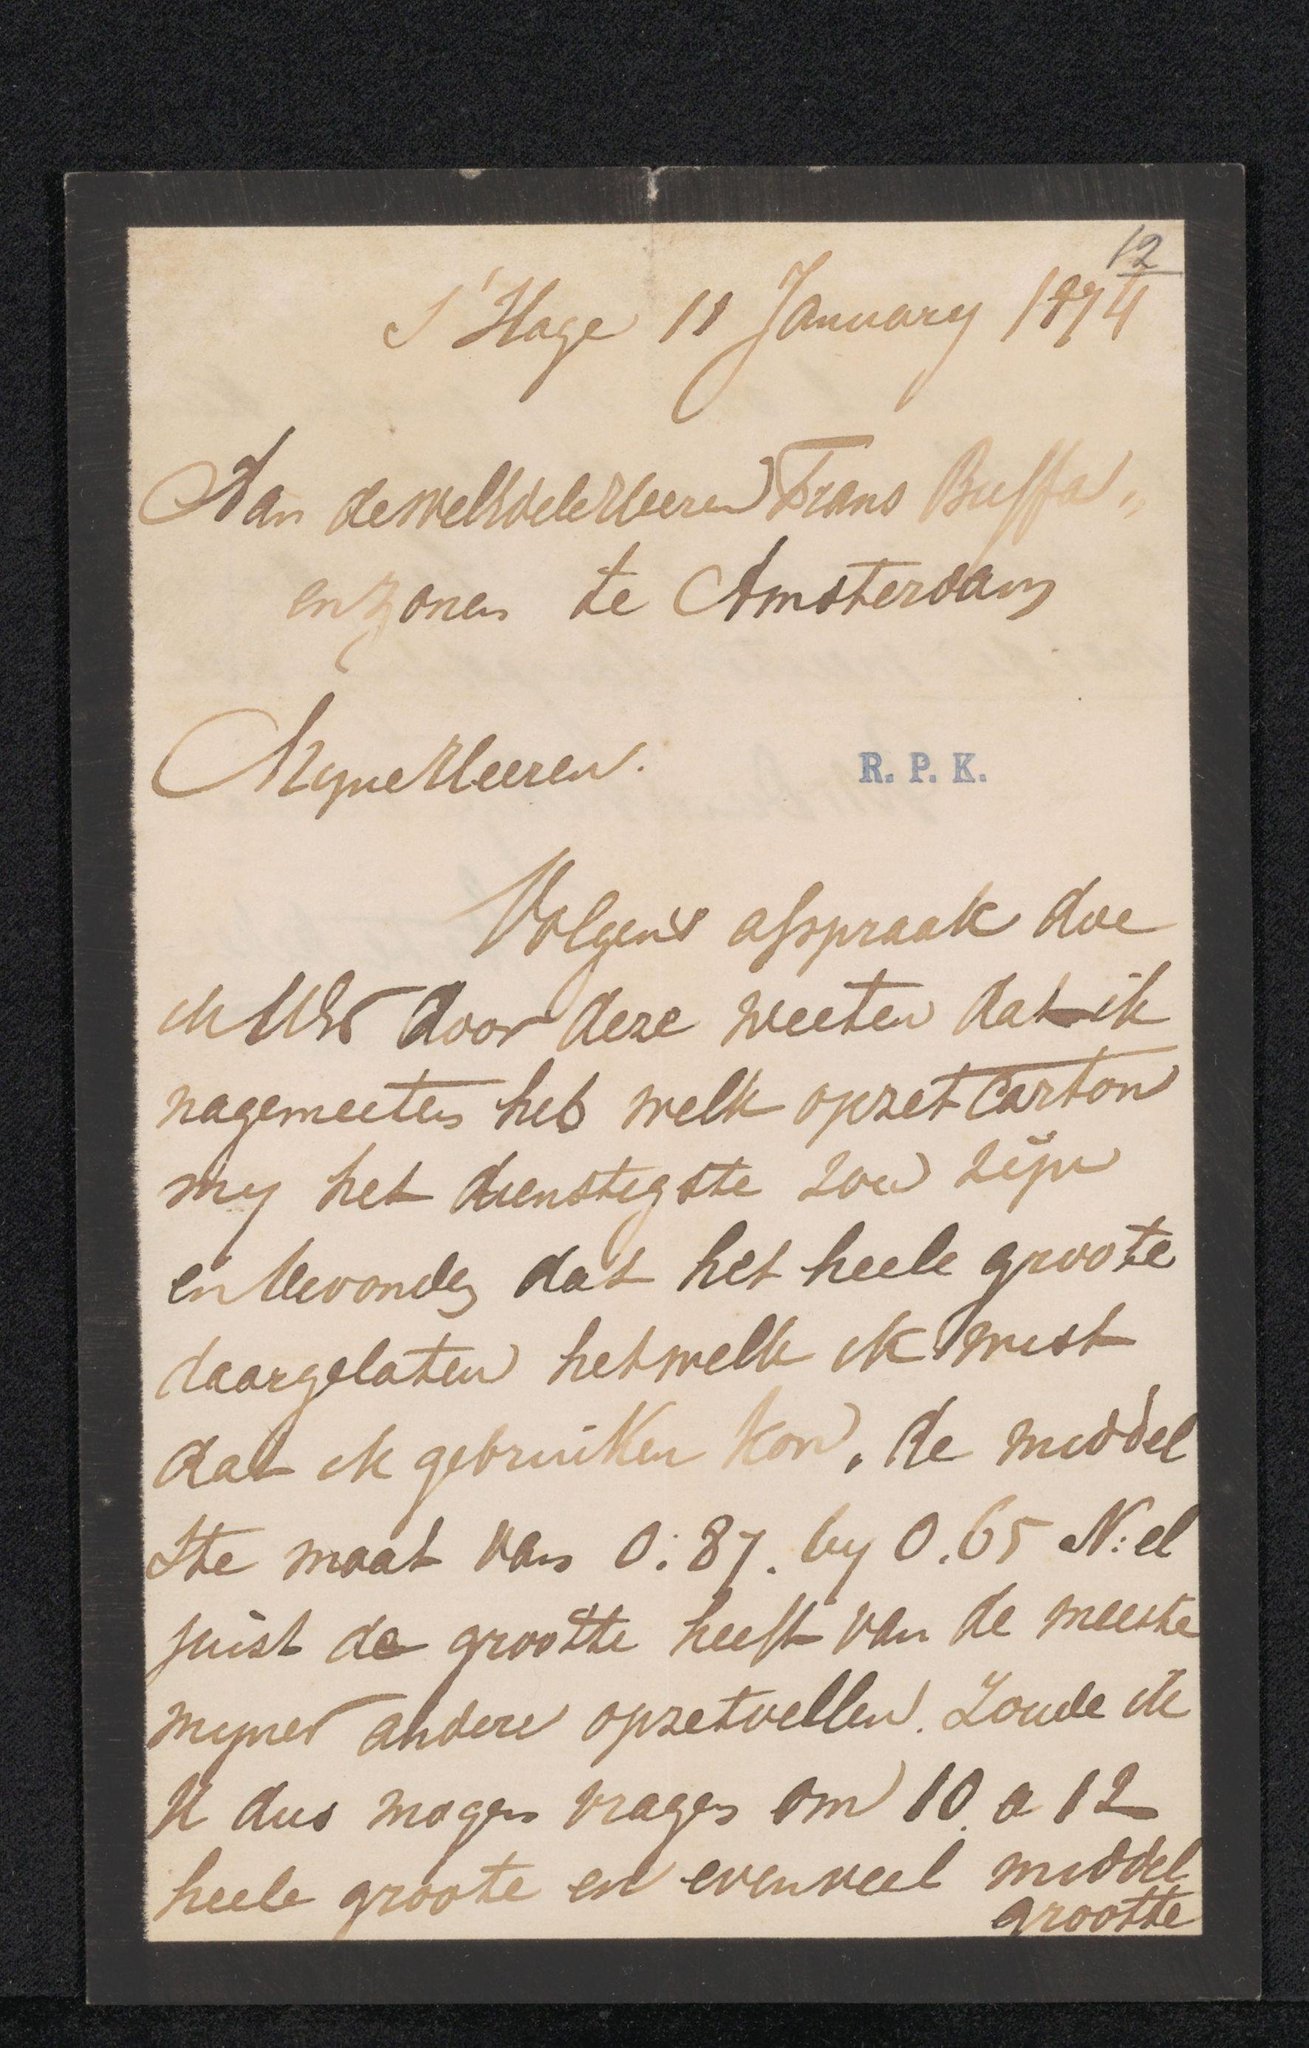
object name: letter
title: Brief aan Frans Buffa en Zonen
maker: pieter stortenbeker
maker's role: draughtsman, painter, print maker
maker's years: 1828-1898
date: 1874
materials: ink, paper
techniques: pen, writing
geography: the hague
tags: publisher, drawing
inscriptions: collector's mark: Lugt 2233